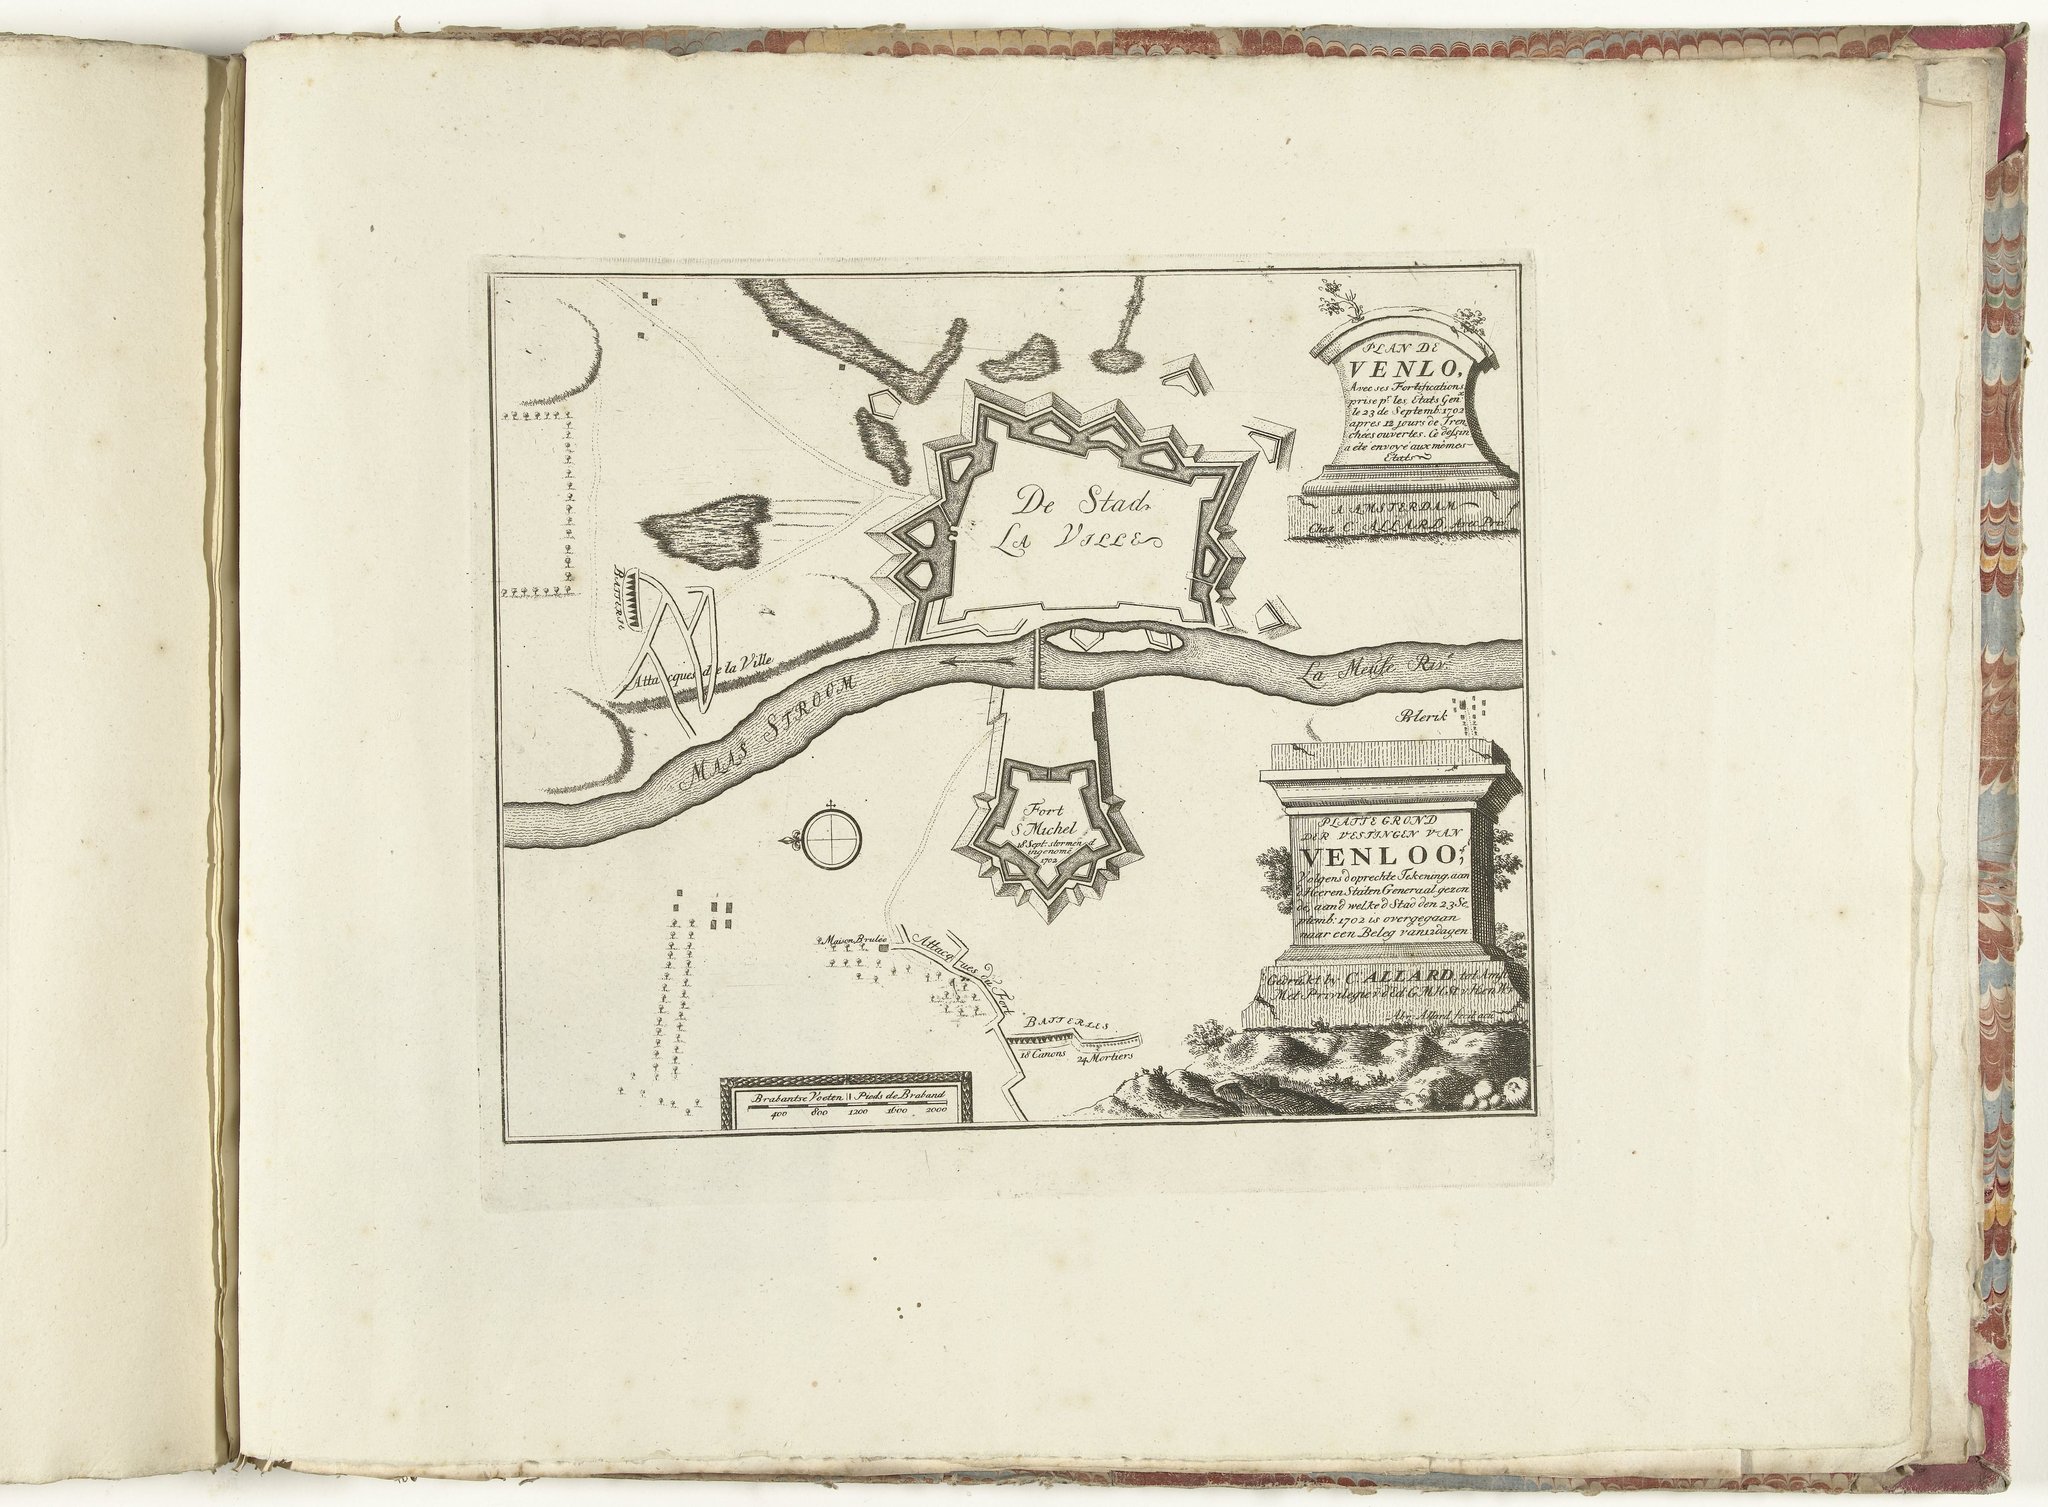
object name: album leaf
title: Plattegrond van Venlo, ca. 1701-1713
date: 1702-1714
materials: paper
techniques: etching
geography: france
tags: maps of cities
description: Gekopieerd naar de Franse prenten in: Nicolas de Fer, Les forces de l'Europe, ou description des principales villes, avec leurs fortifications : dessignées par les meilleurs ingenieurs, particulierement celles ... de la France, dont les plans ont esté levez par M. de Vauban, Nicolas de Fer, Parijs 1693-1696, of andere voorbeelden.